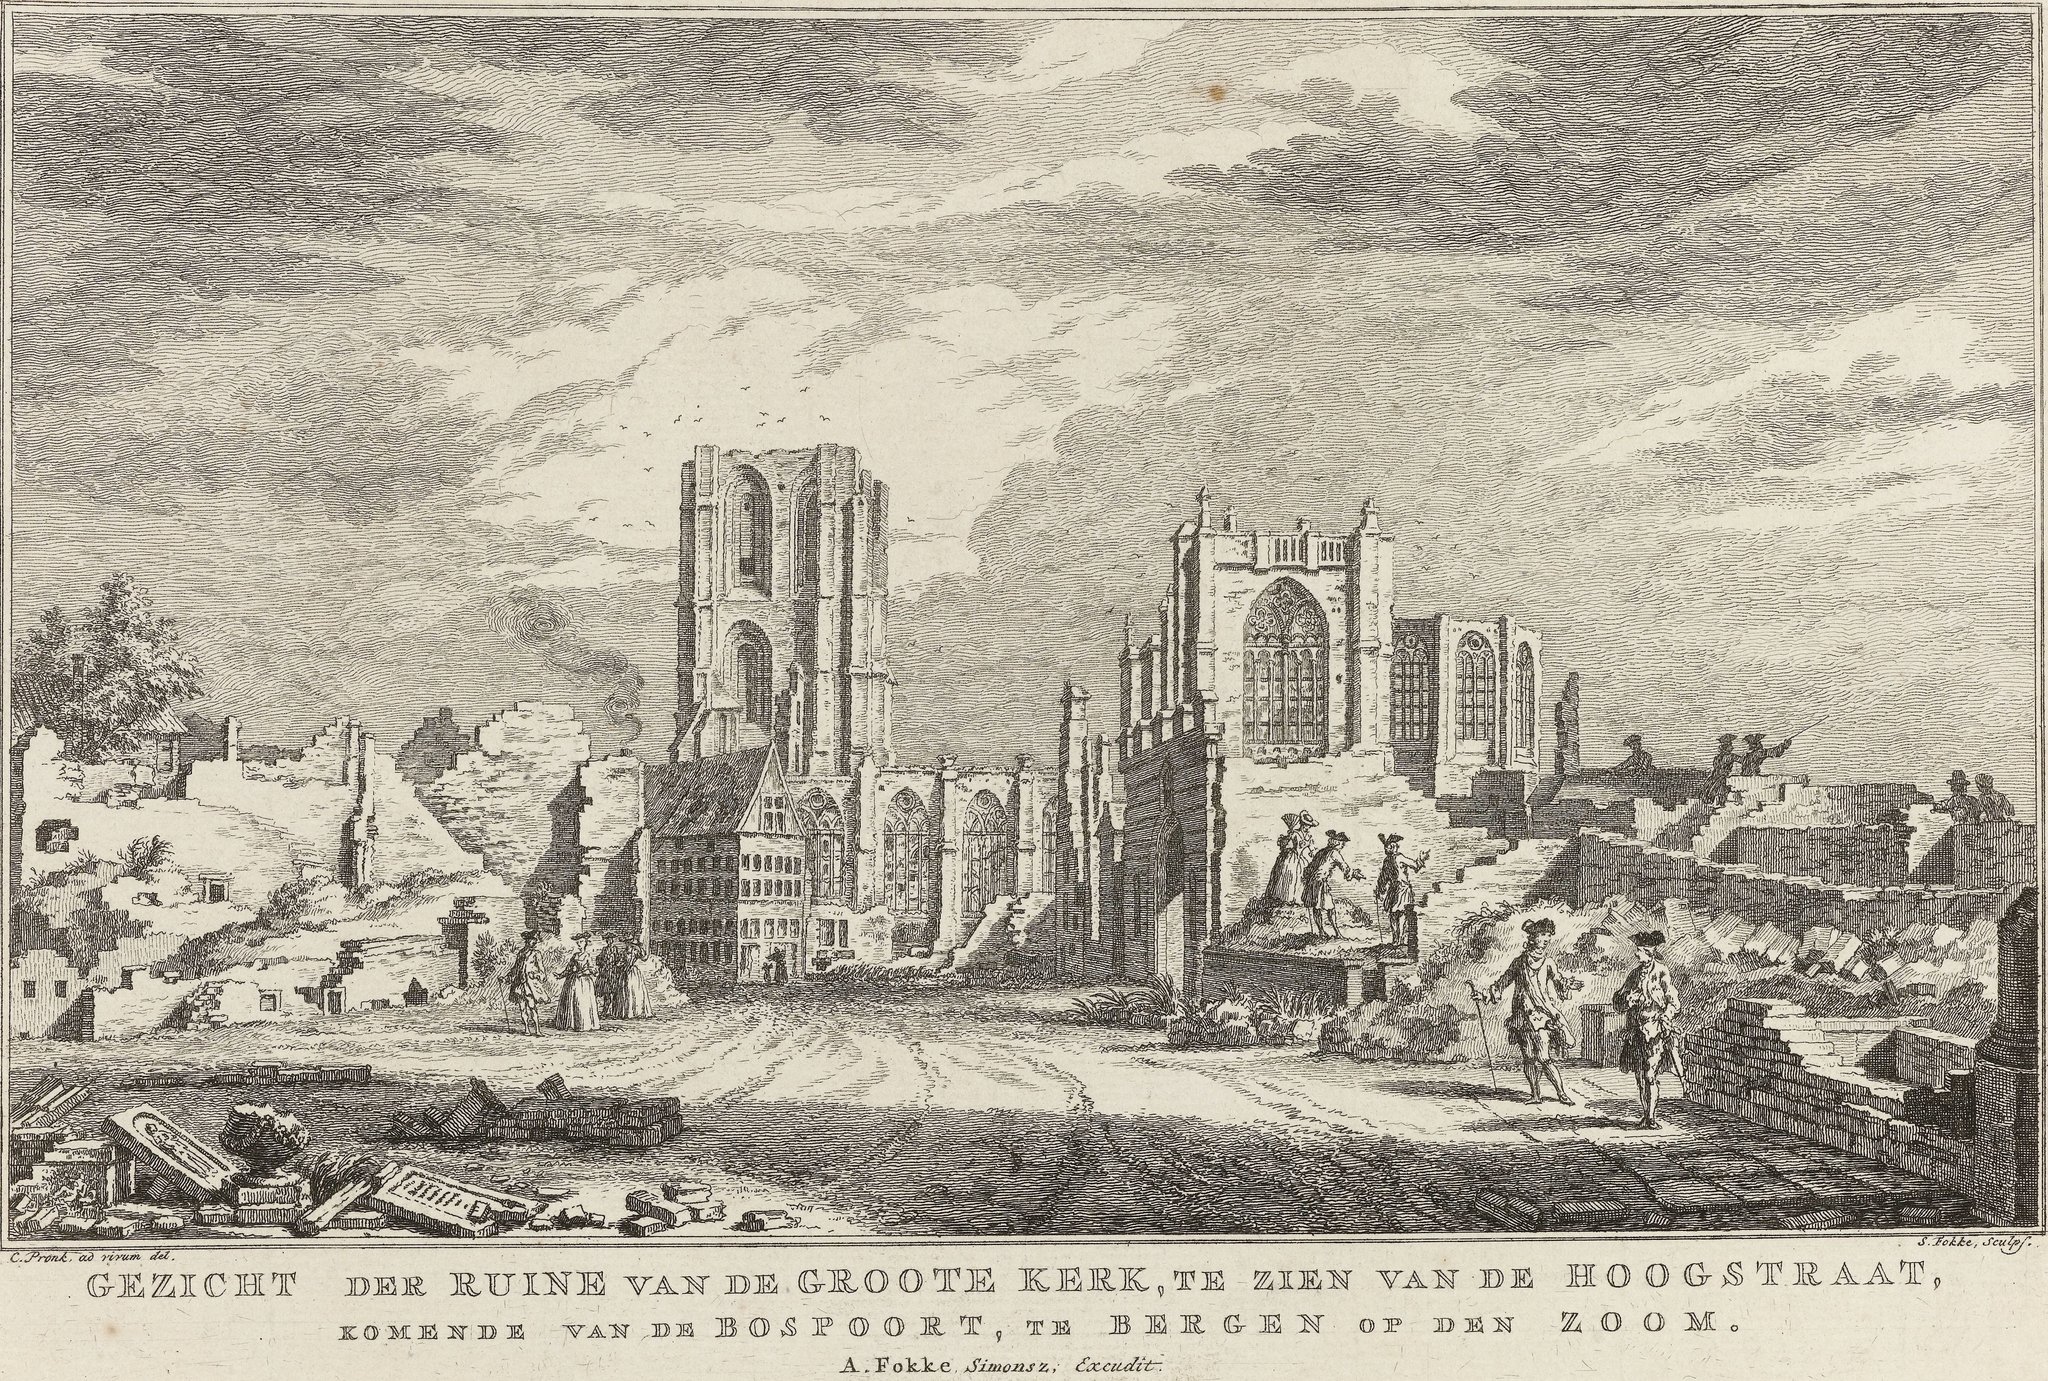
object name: print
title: Ruïne van de Grote Kerk van Bergen op Zoom, 1748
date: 1772-1780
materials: paper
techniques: etching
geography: amsterdam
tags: ruin of church, monastery, etc., devastated, ruined place or city (~ warfare), bergen op zoom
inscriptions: collector's mark: Lugt 2233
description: Prent ook gebruikt in: Beschryving der stad Bergen op den Zoom (…). 1e druk. Amsterdam: Arend Fokke Simonsz., 1780. Muller geeft aan dat de prenten door Simon Fokke in 1772 naar de tekeningen van Pronk uit 1748 zijn vervaardigd. In de Collecties Thuis in Brabant (collecties in Brabantse musea en archieven) is een ontwerptekening (met inv.nr.: BC-Tha oai:tha.uvt.nl:709121) voor deze prent in de serie bewaard met de annotatie: Hoogstraat. na t Leven geschest (sic) door C.Pronk 1748. opgetekent door S. Fokke 1772.